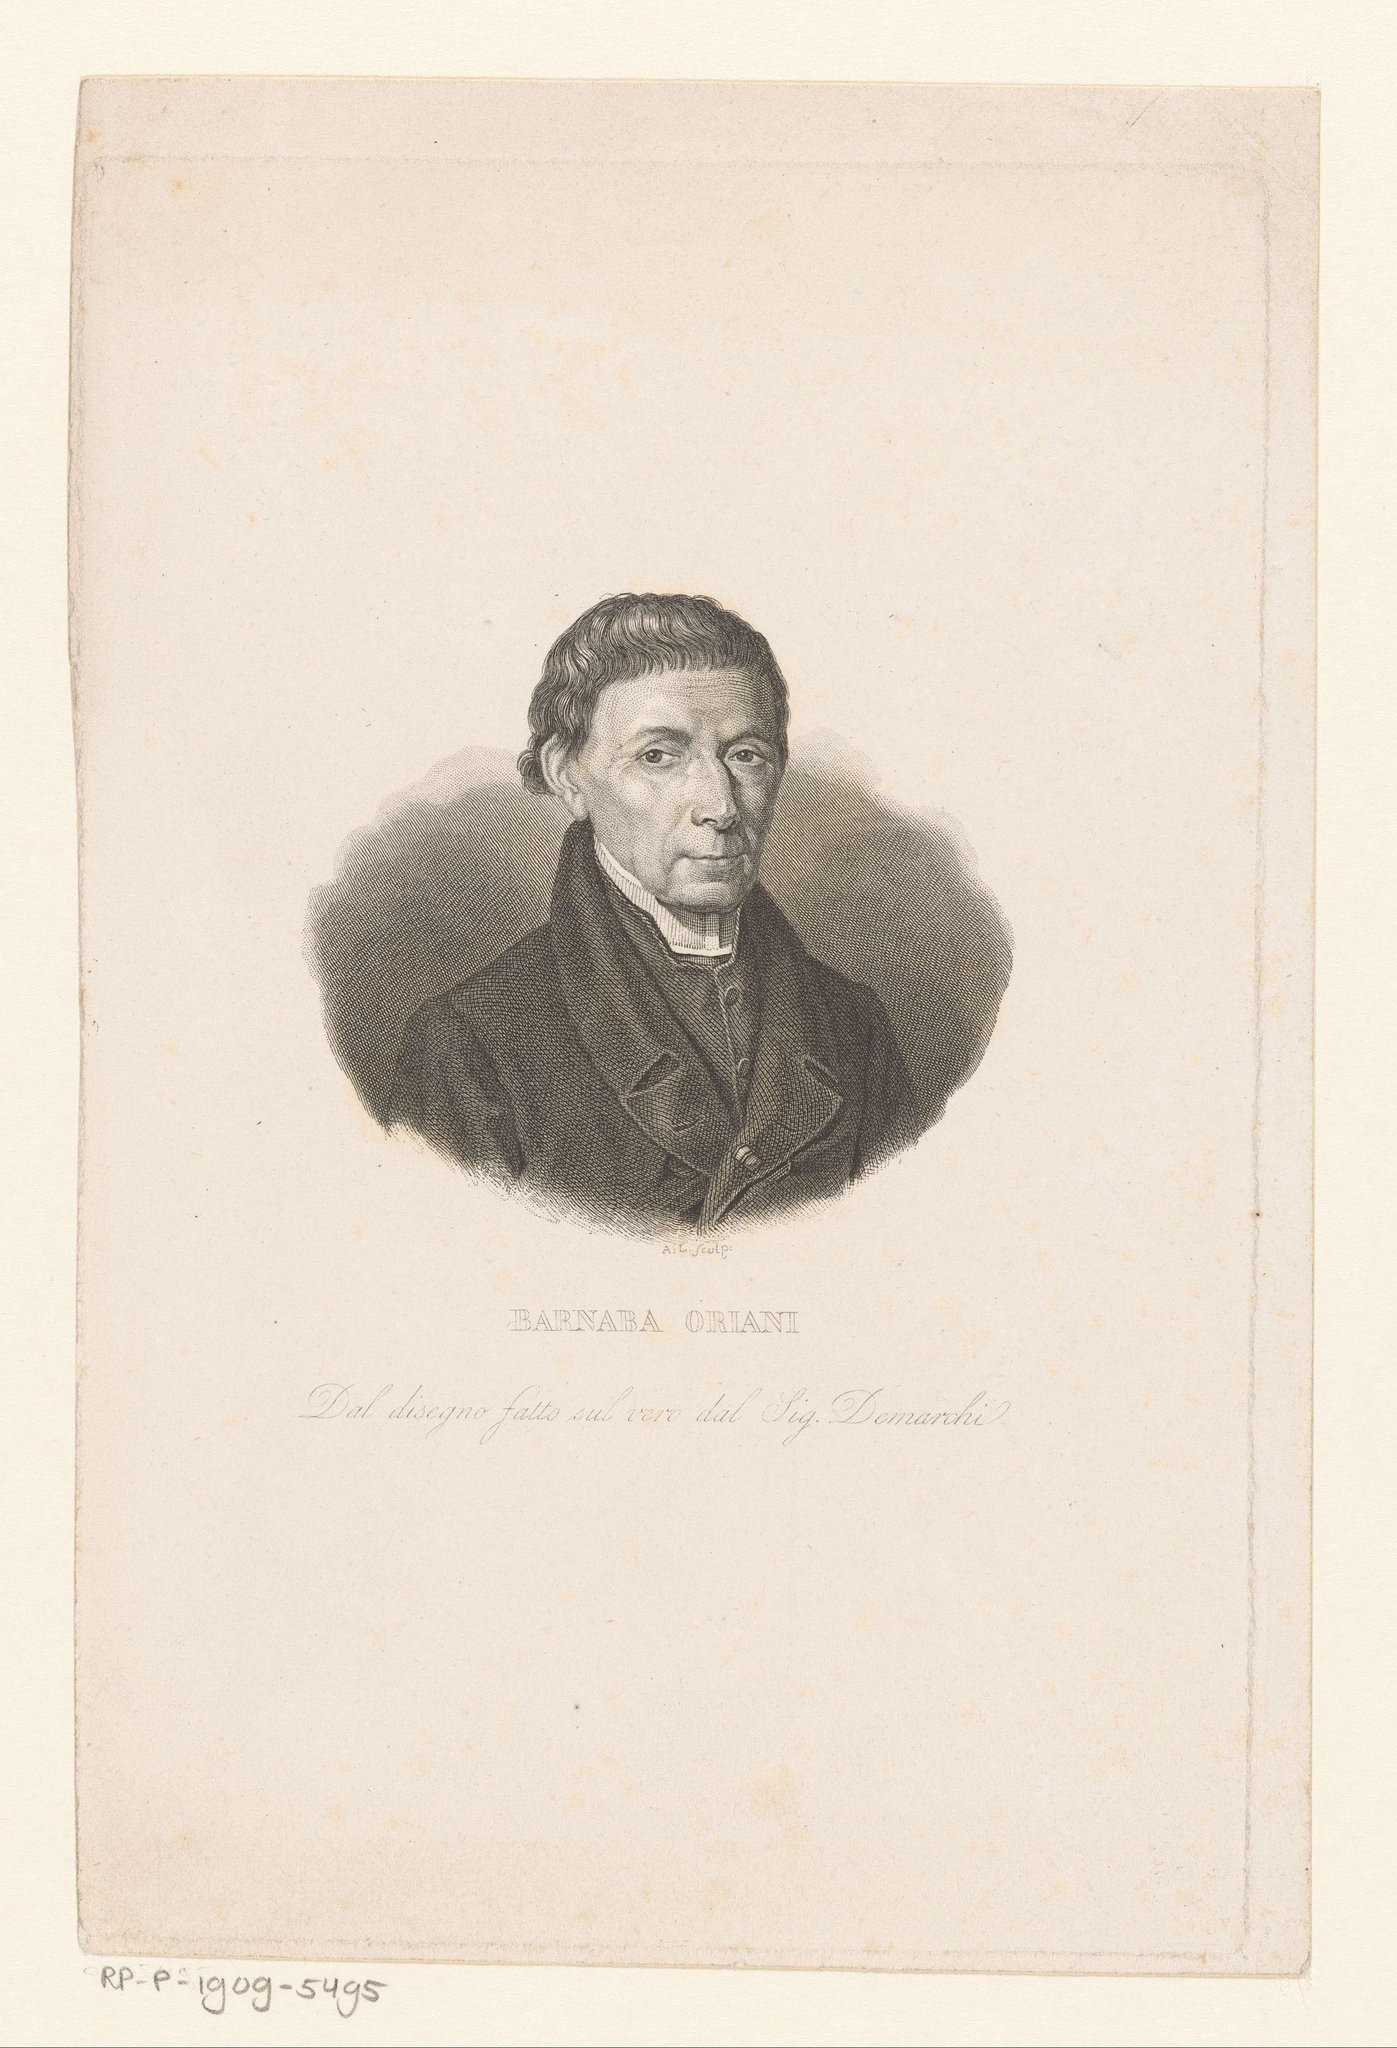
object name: print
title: Portret van wiskundige en astronoom Barnaba Oriani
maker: monogrammist al (19e eeuw)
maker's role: print maker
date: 1800-1899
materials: paper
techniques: engraving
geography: italy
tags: priest, historical persons, science and technology (+ portrait of scholar, scientist)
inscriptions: collector's mark: Lugt 240